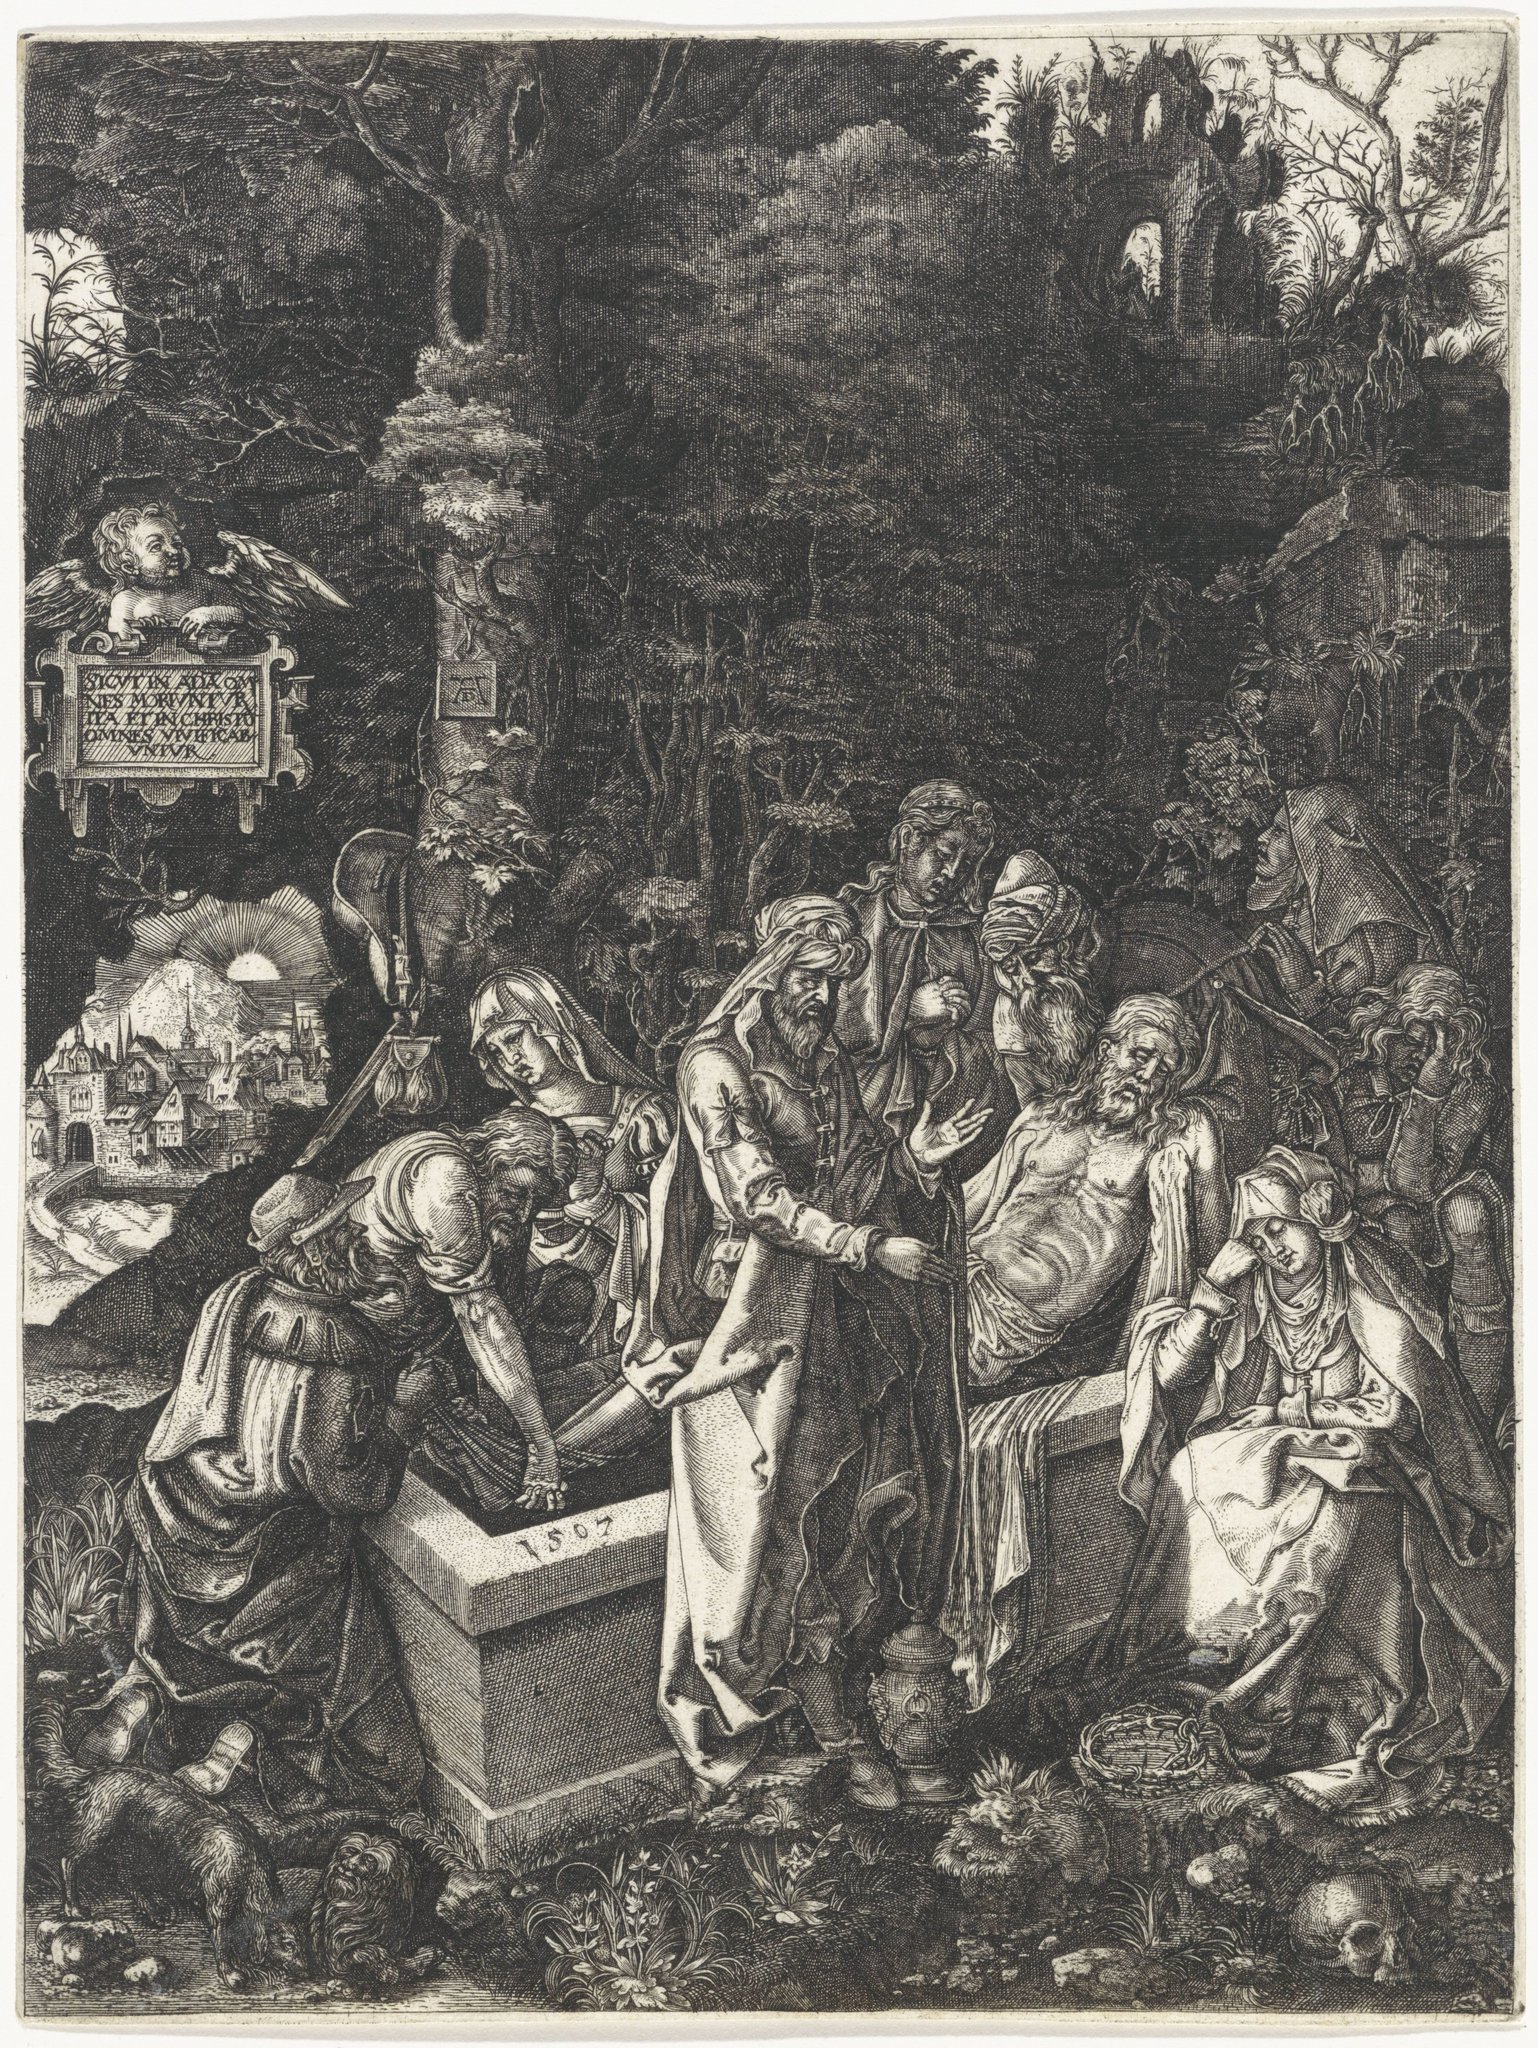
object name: print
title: Graflegging van Christus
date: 1507-1578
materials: paper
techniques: engraving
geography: nuremberg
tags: christ's entombment (possibly by angels)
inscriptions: collector's mark: Lugt 240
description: Het lichaam van Christus wordt door Nikodemus en Jozef van Arimatea in een graftombe onder een boom gelegd. De overige figuren rond het graf rouwen. Aan de voeten van Maria ligt de doornenkroon. Een engel houdt een cartouche met een Latijnse tekst omhoog.